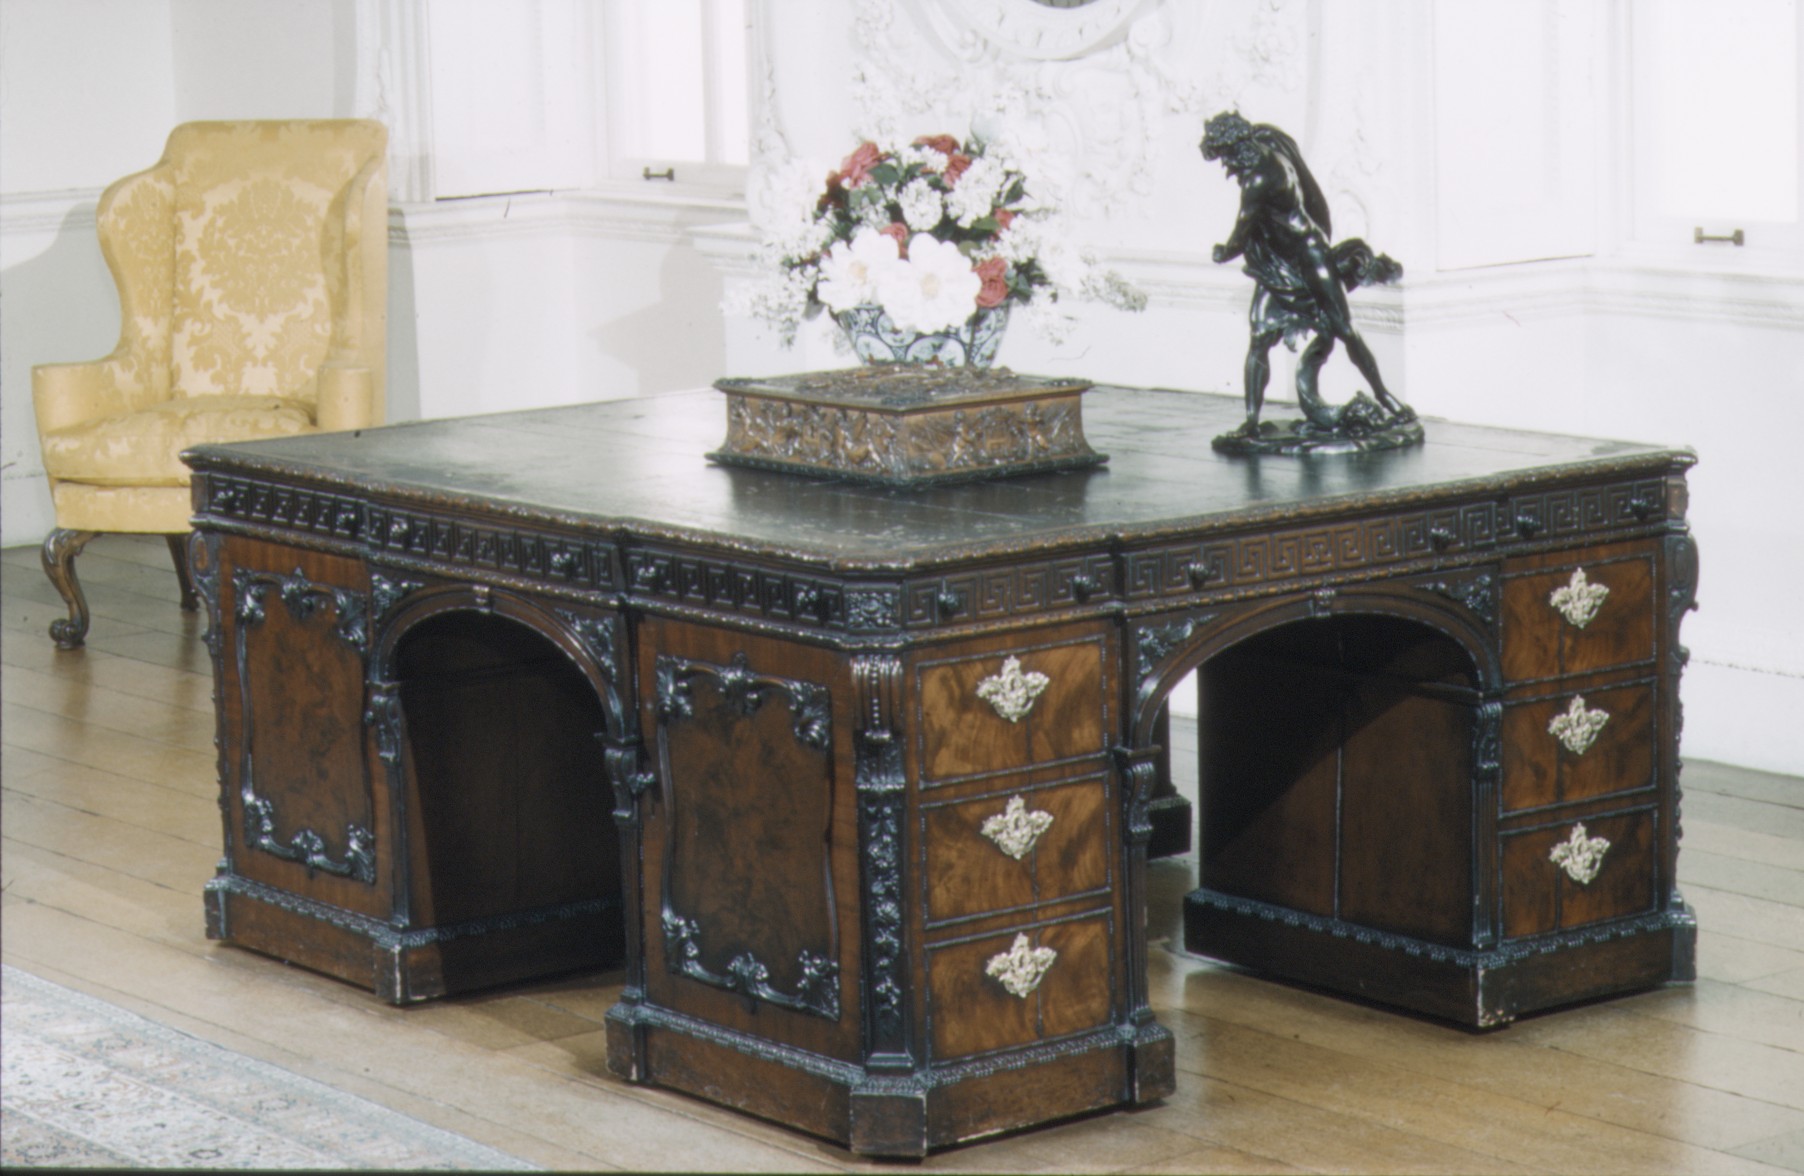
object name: library table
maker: william vile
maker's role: maker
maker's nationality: british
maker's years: 1715-1767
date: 1760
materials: wood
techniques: veneering